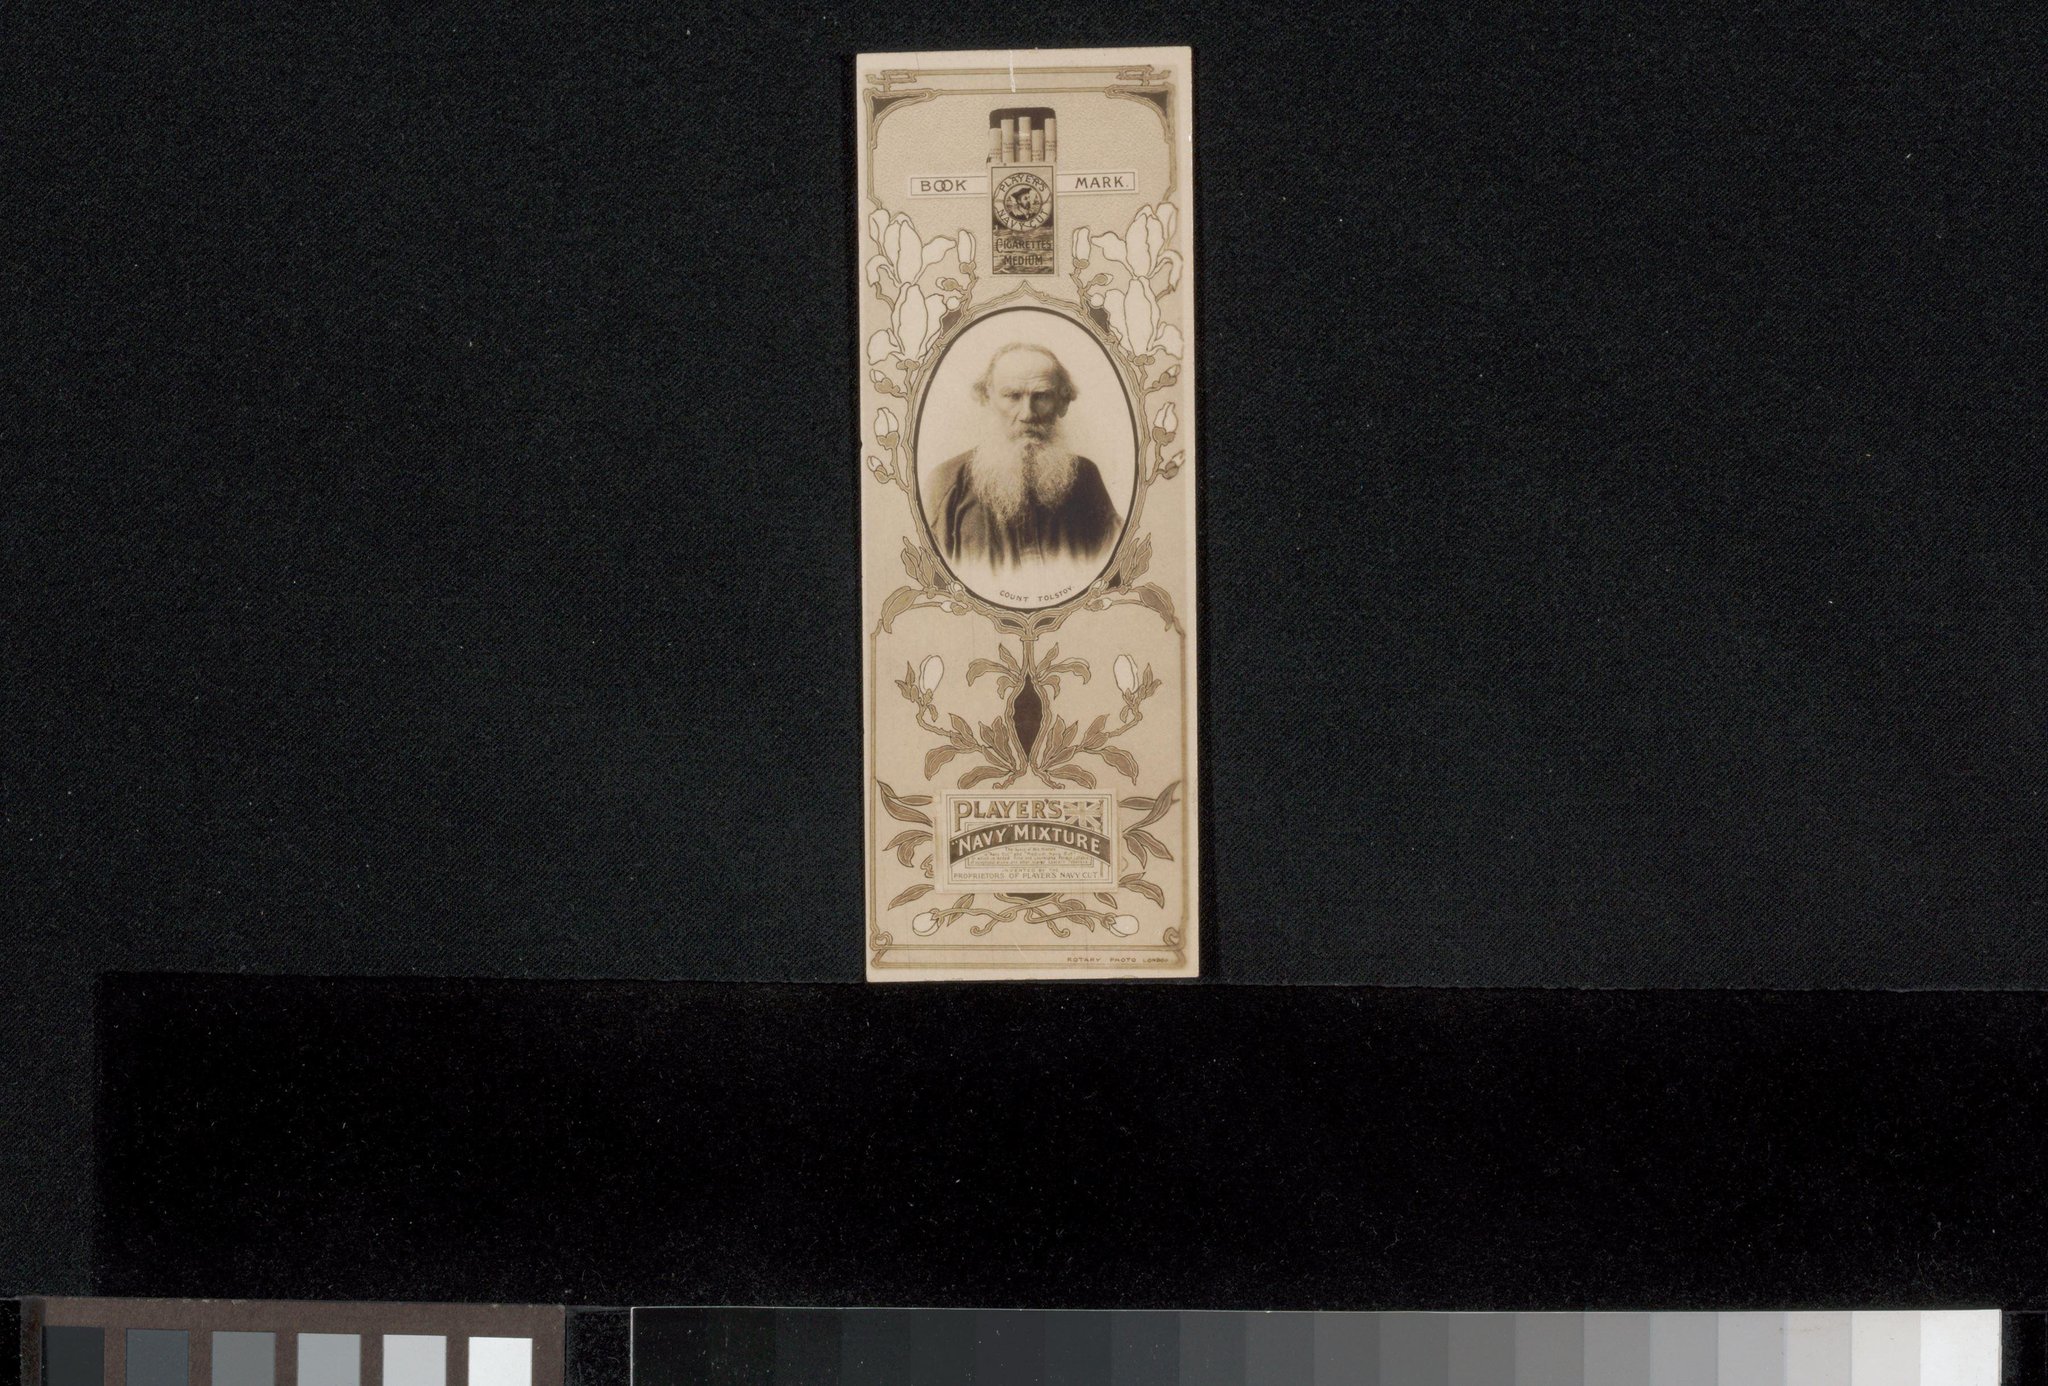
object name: bookmark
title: Boekenlegger uit archief Philip Zilcken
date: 1898-1910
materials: cardboard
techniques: gelatin silver print, printing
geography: london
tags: lev tolstoj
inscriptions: collector's mark: ‘RPK’